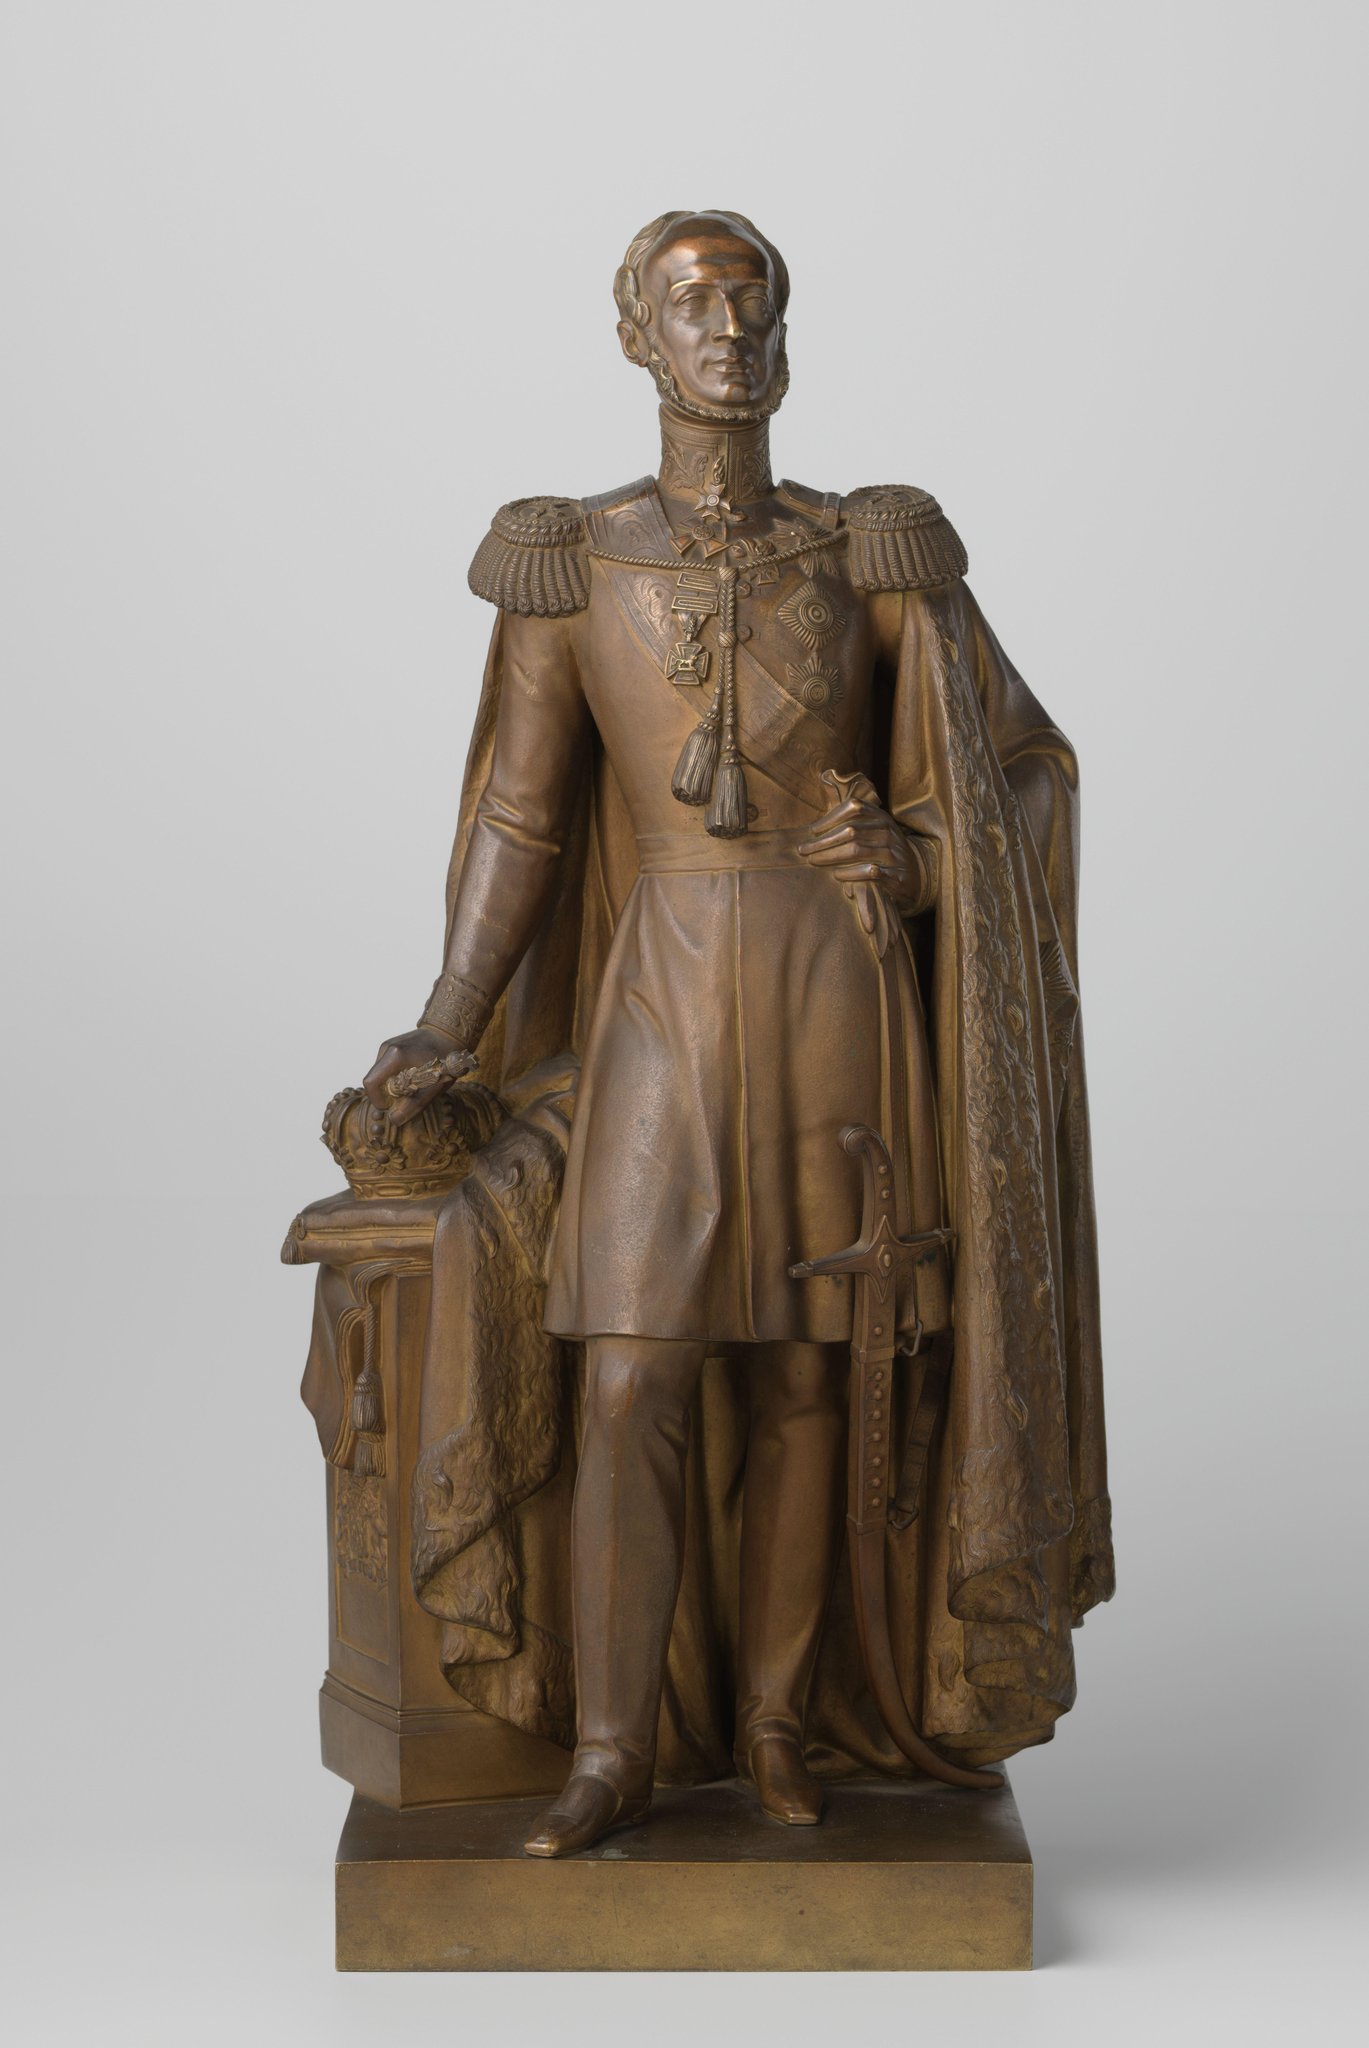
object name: sculpture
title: Koning Willem II (1792-1849)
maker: jozef geefs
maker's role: sculptor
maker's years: 1808-1885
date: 1844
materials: bronze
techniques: casting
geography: antwerp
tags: the hague, william ii of the netherlands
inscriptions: signature and date: ‘Jozef Geefs fecit 1844’, inscription: ‘Willem II Koning der Nederlanden’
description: Model voor het standbeeld dat in 23 maart 1854 voor hem werd opgericht op het Buitenhof te Den Haag maar dat in 1924 werd overgebracht naar het Heuvelplein te Tilburg. Het beeld in marmer bevond zich in 1973 in het koninklijk paleis te Soestdijk.